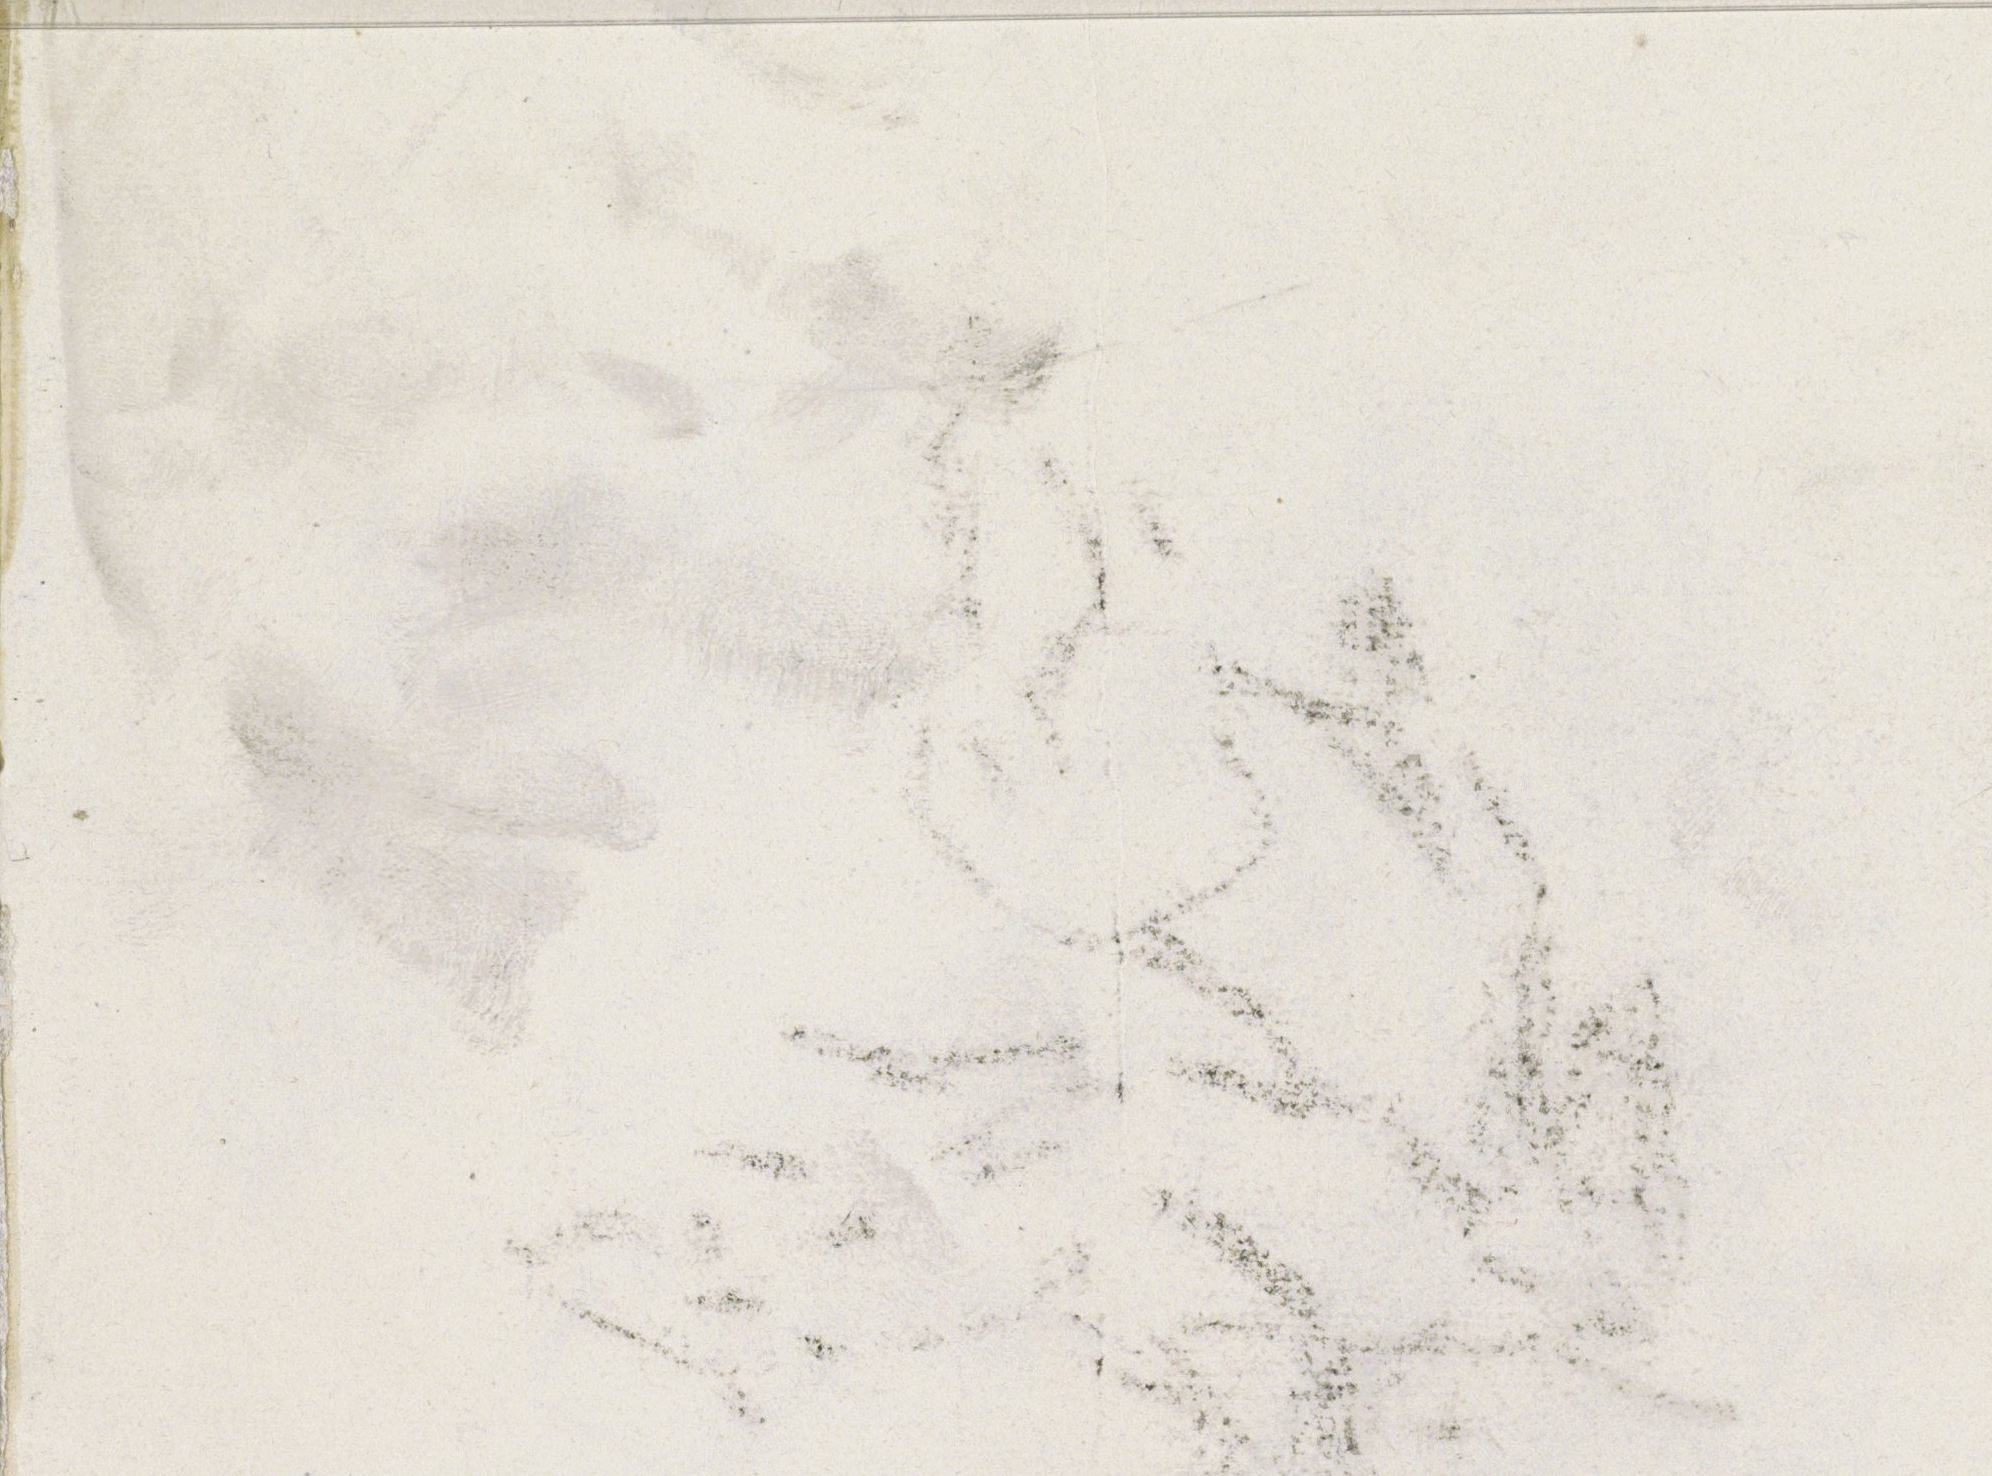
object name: sketchbook leaf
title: Abklatsch van de krijttekening op pagina 2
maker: isaac israels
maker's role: draughtsman, painter, print maker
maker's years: 1865-1934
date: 1875-1934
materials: paper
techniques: printmaking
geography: the hague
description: Pagina 3 uit schetsboek XLI met 38 pagina's.